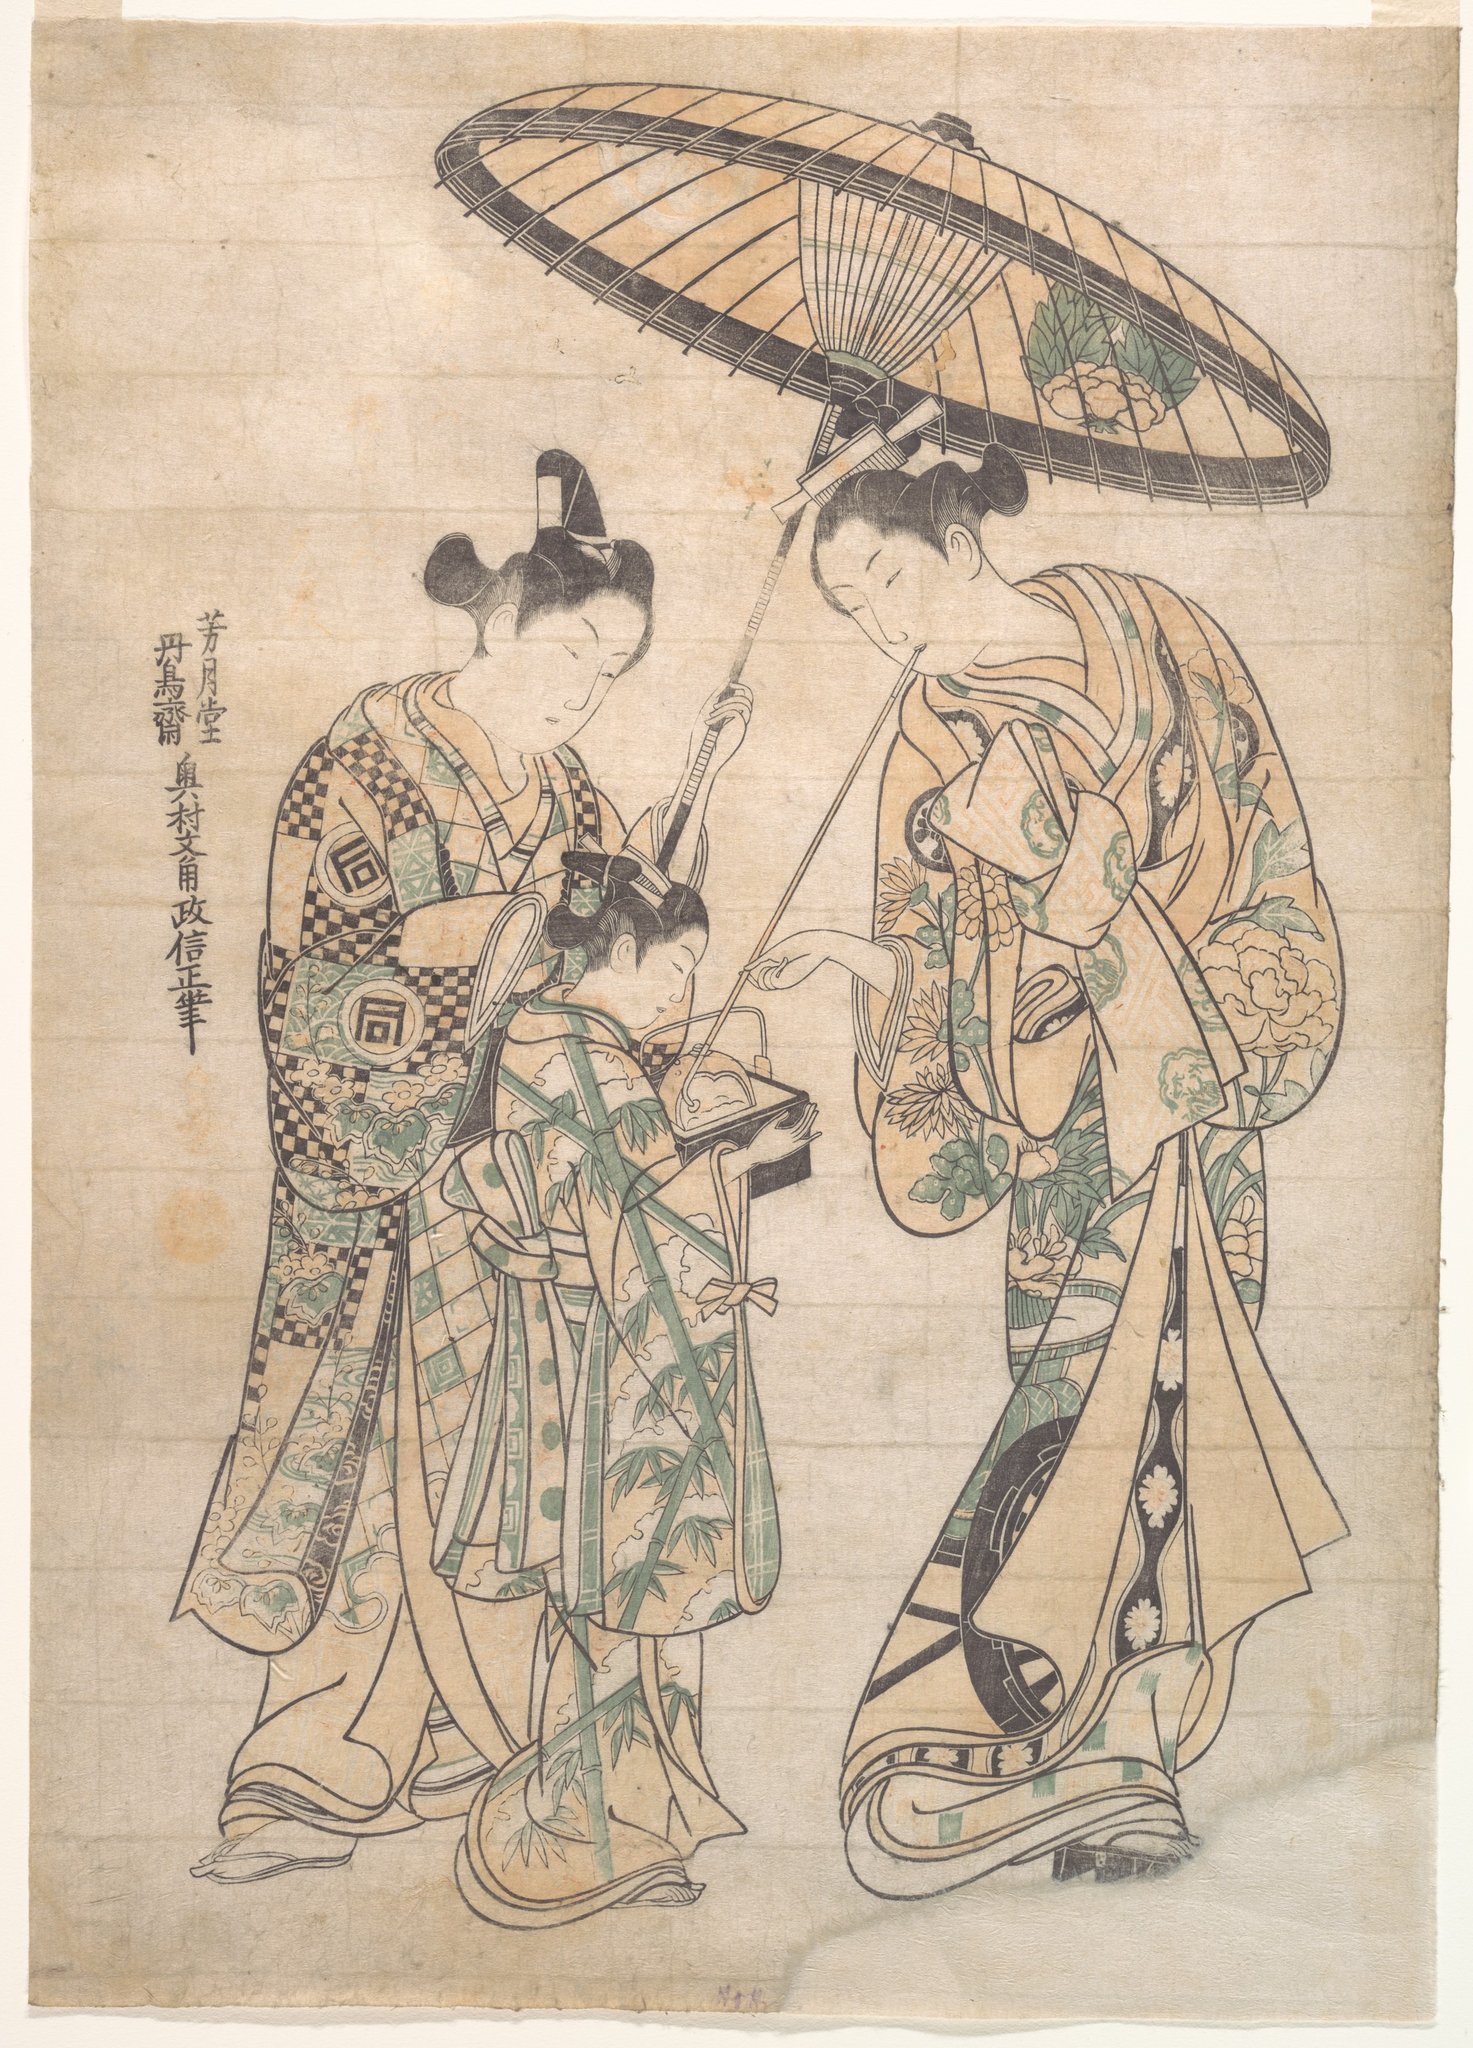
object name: print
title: Two Figures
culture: japanese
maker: okumura masanobu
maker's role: artist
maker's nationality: japanese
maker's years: 1686-1764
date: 1691-1768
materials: ink, paper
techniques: woodblock print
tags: girls,women